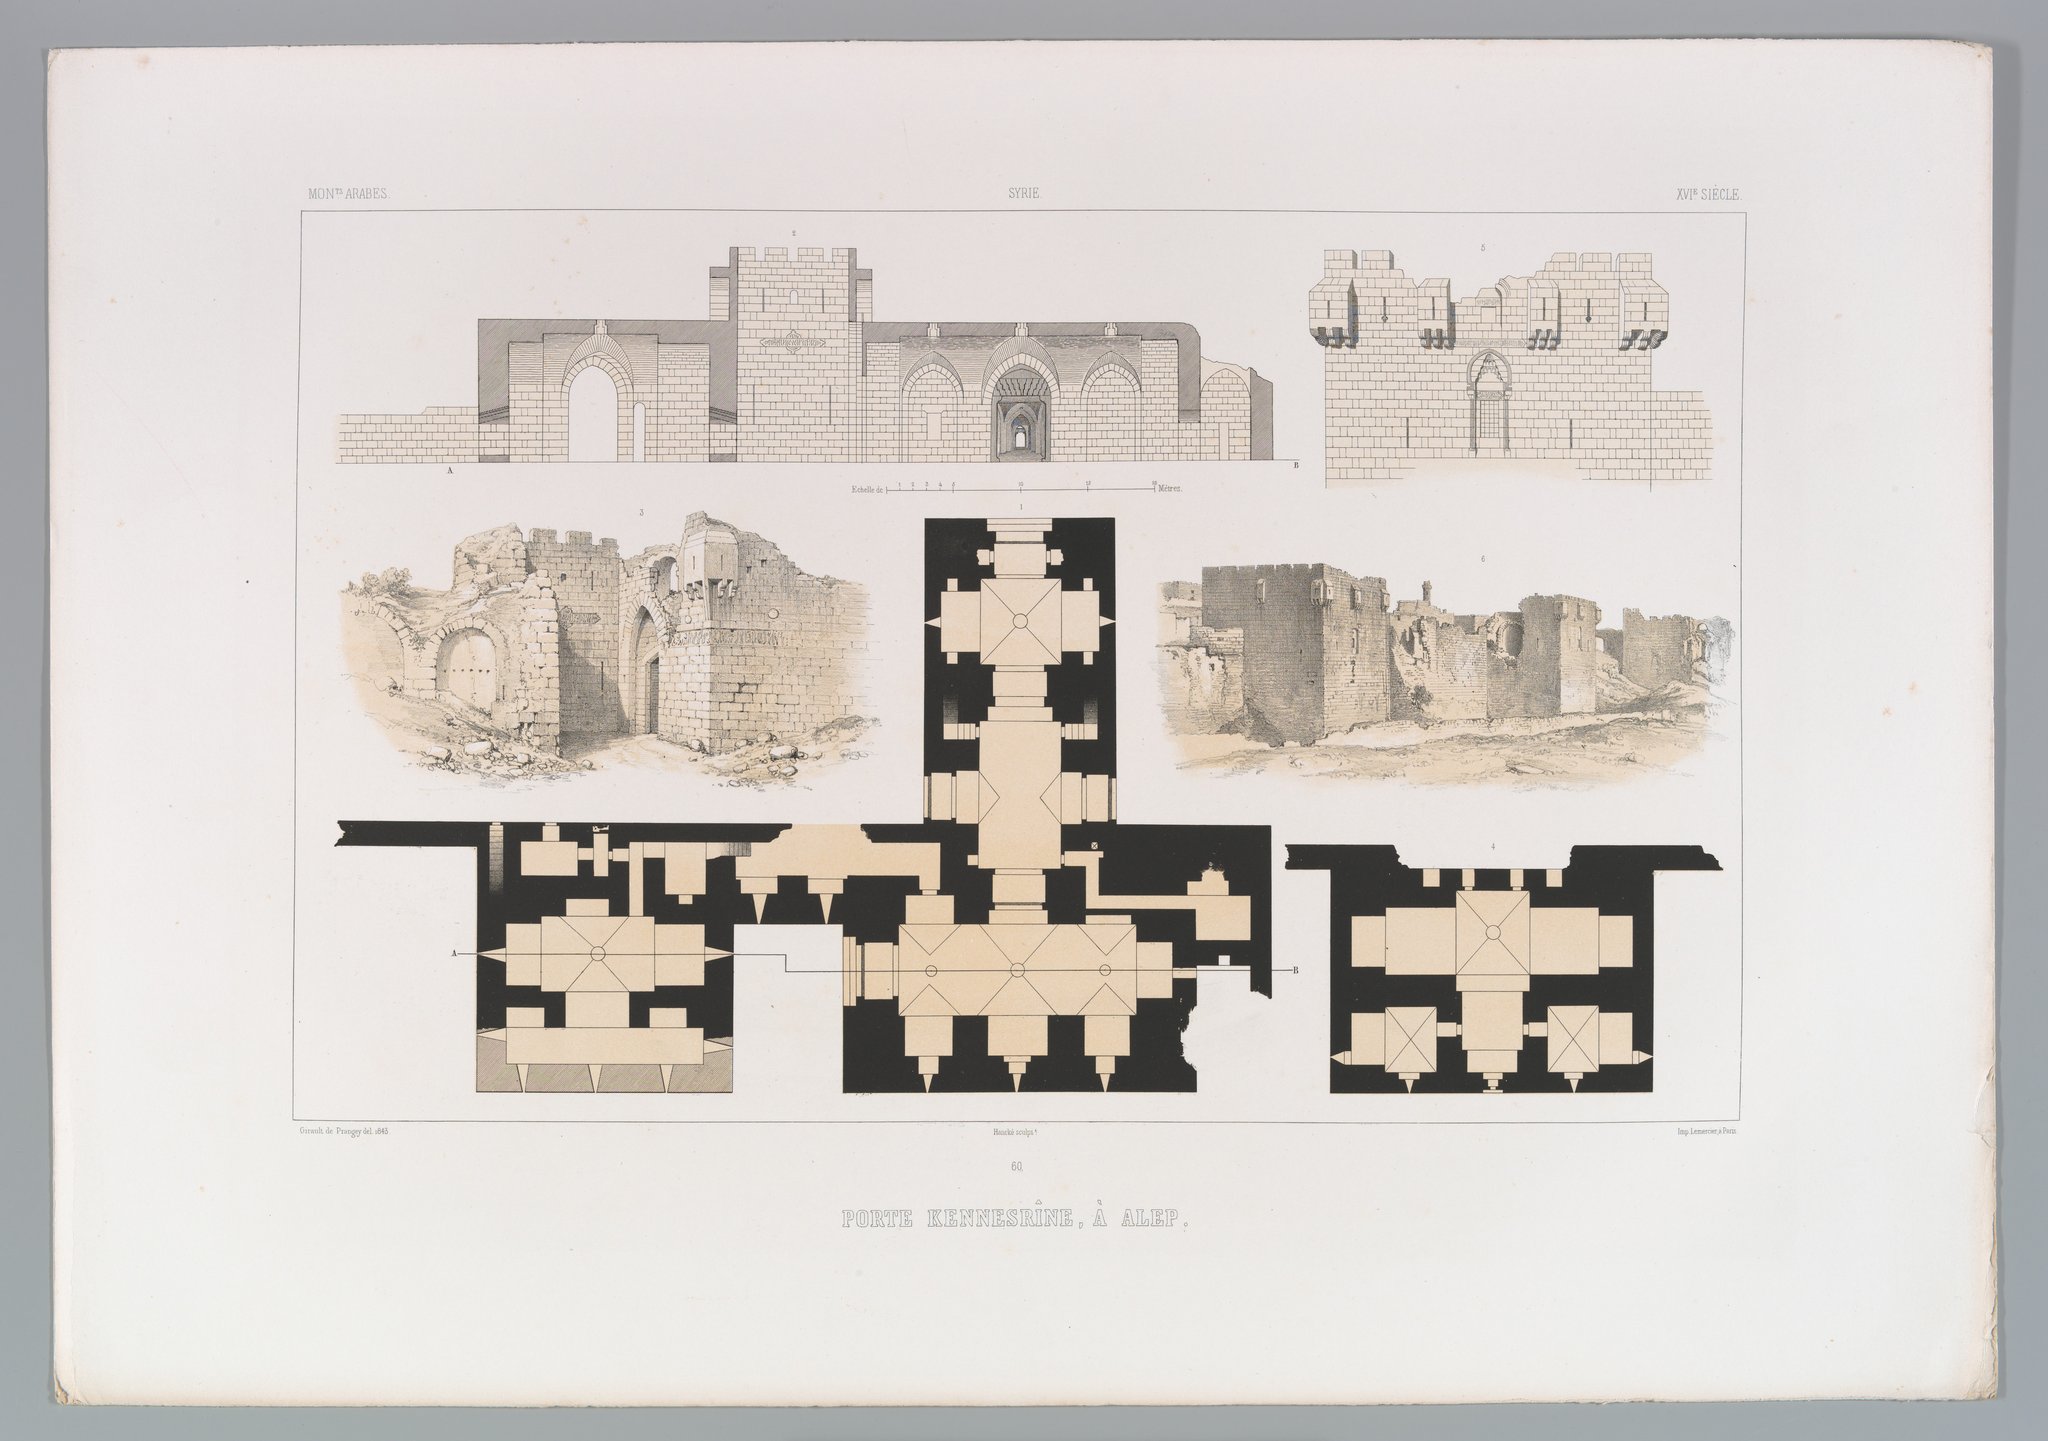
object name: lithograph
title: 60. Porte Kennesrîne, à Alep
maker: joseph-philibert girault de prangey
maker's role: artist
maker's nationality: french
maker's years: 1804-1892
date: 1843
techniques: lithograph